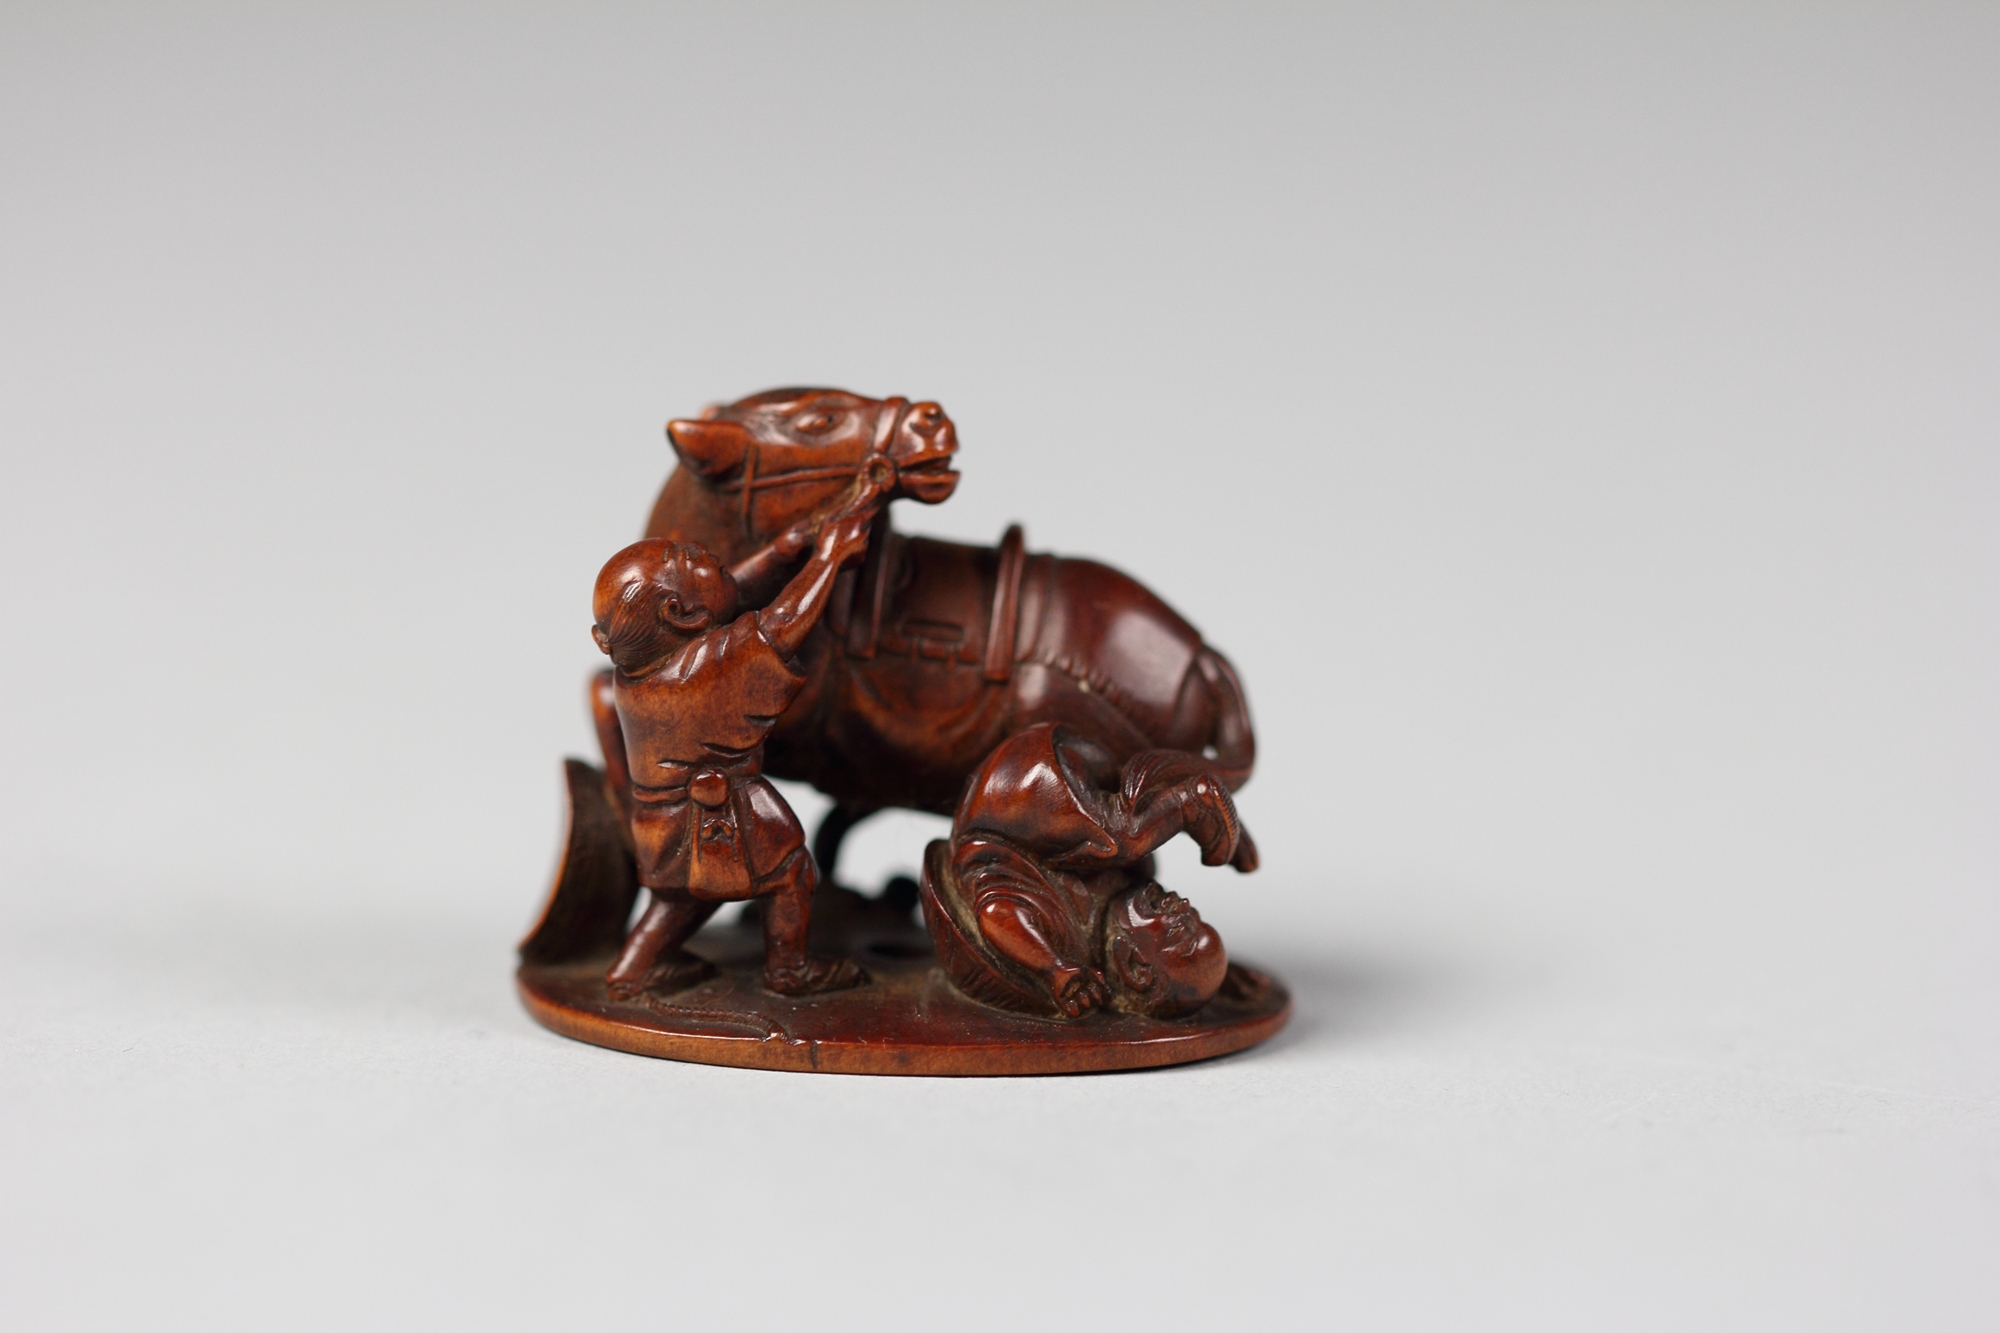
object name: netsuke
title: Netsuke of Two Men and Horse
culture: japanese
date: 1701-1800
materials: wood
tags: horses